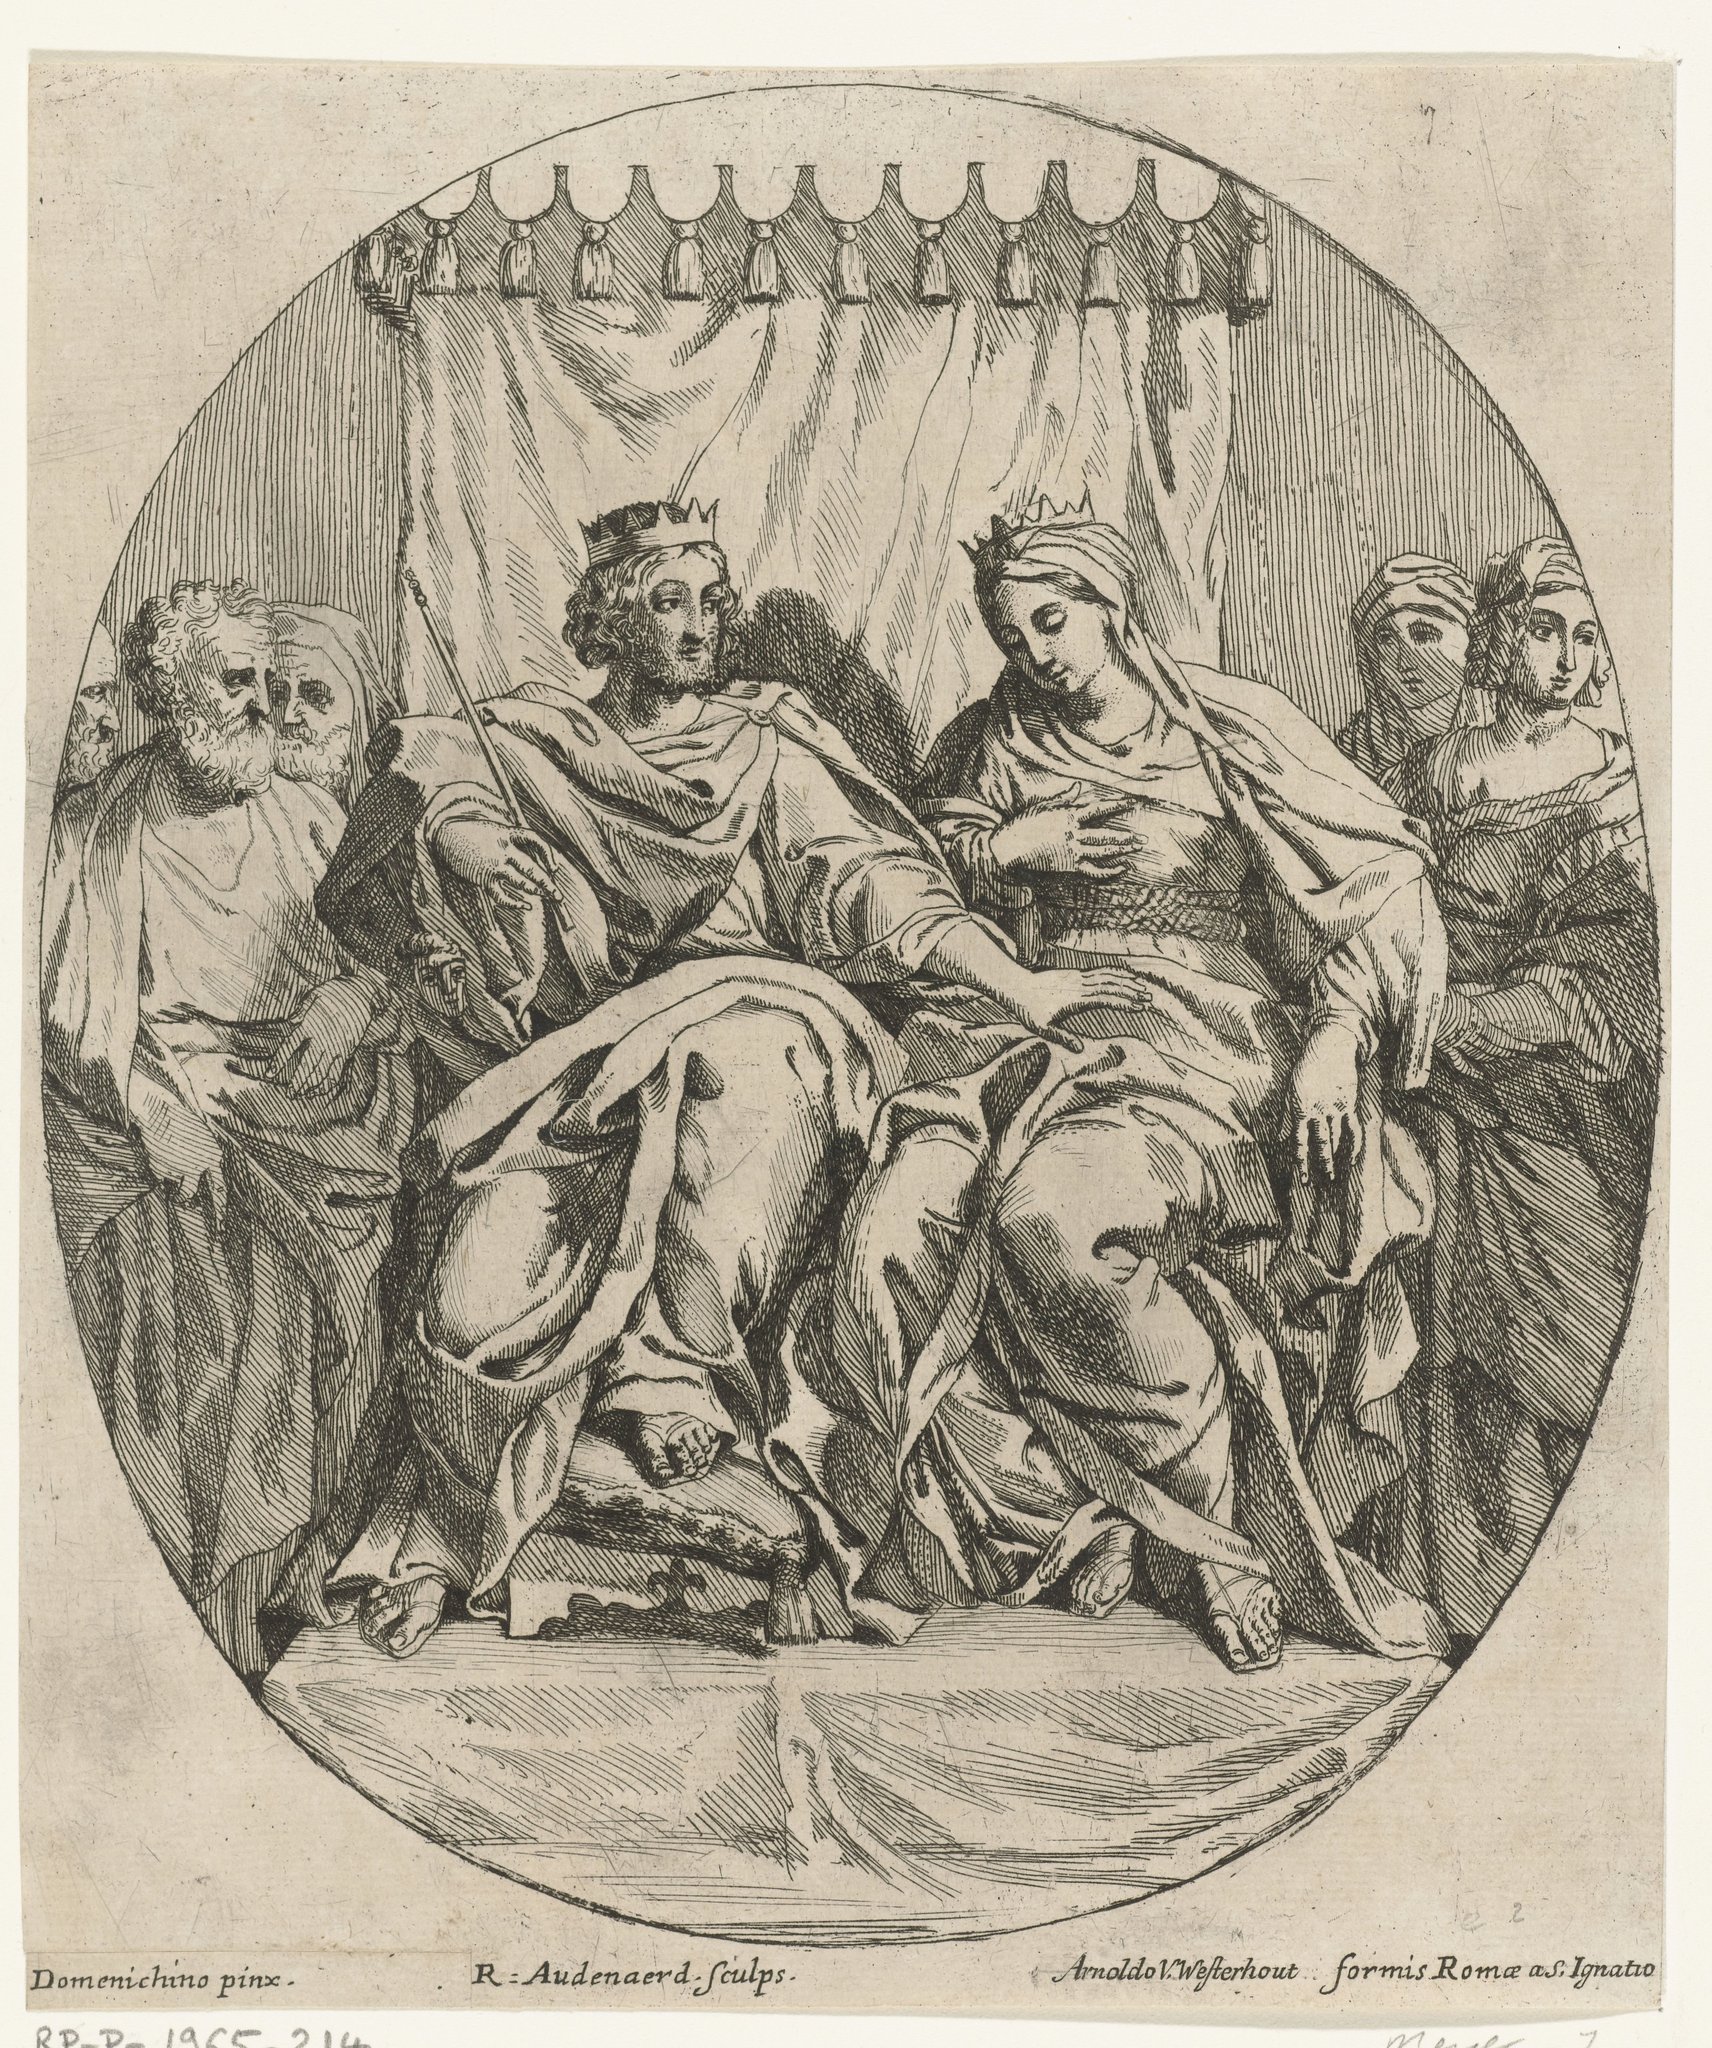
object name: print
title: Salomo en Batseba op de troon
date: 1685-1725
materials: paper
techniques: etching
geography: rome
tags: bathsheba enthroned at solomon's right hand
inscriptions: collector's mark: Lugt 2228, collector's mark: Lugt 2760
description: Salomo en zijn moeder Batseba zitten op de troon. Prent uit een serie van vier voorstellingen uit het Oude Testament naar fresco's van Domenichino.